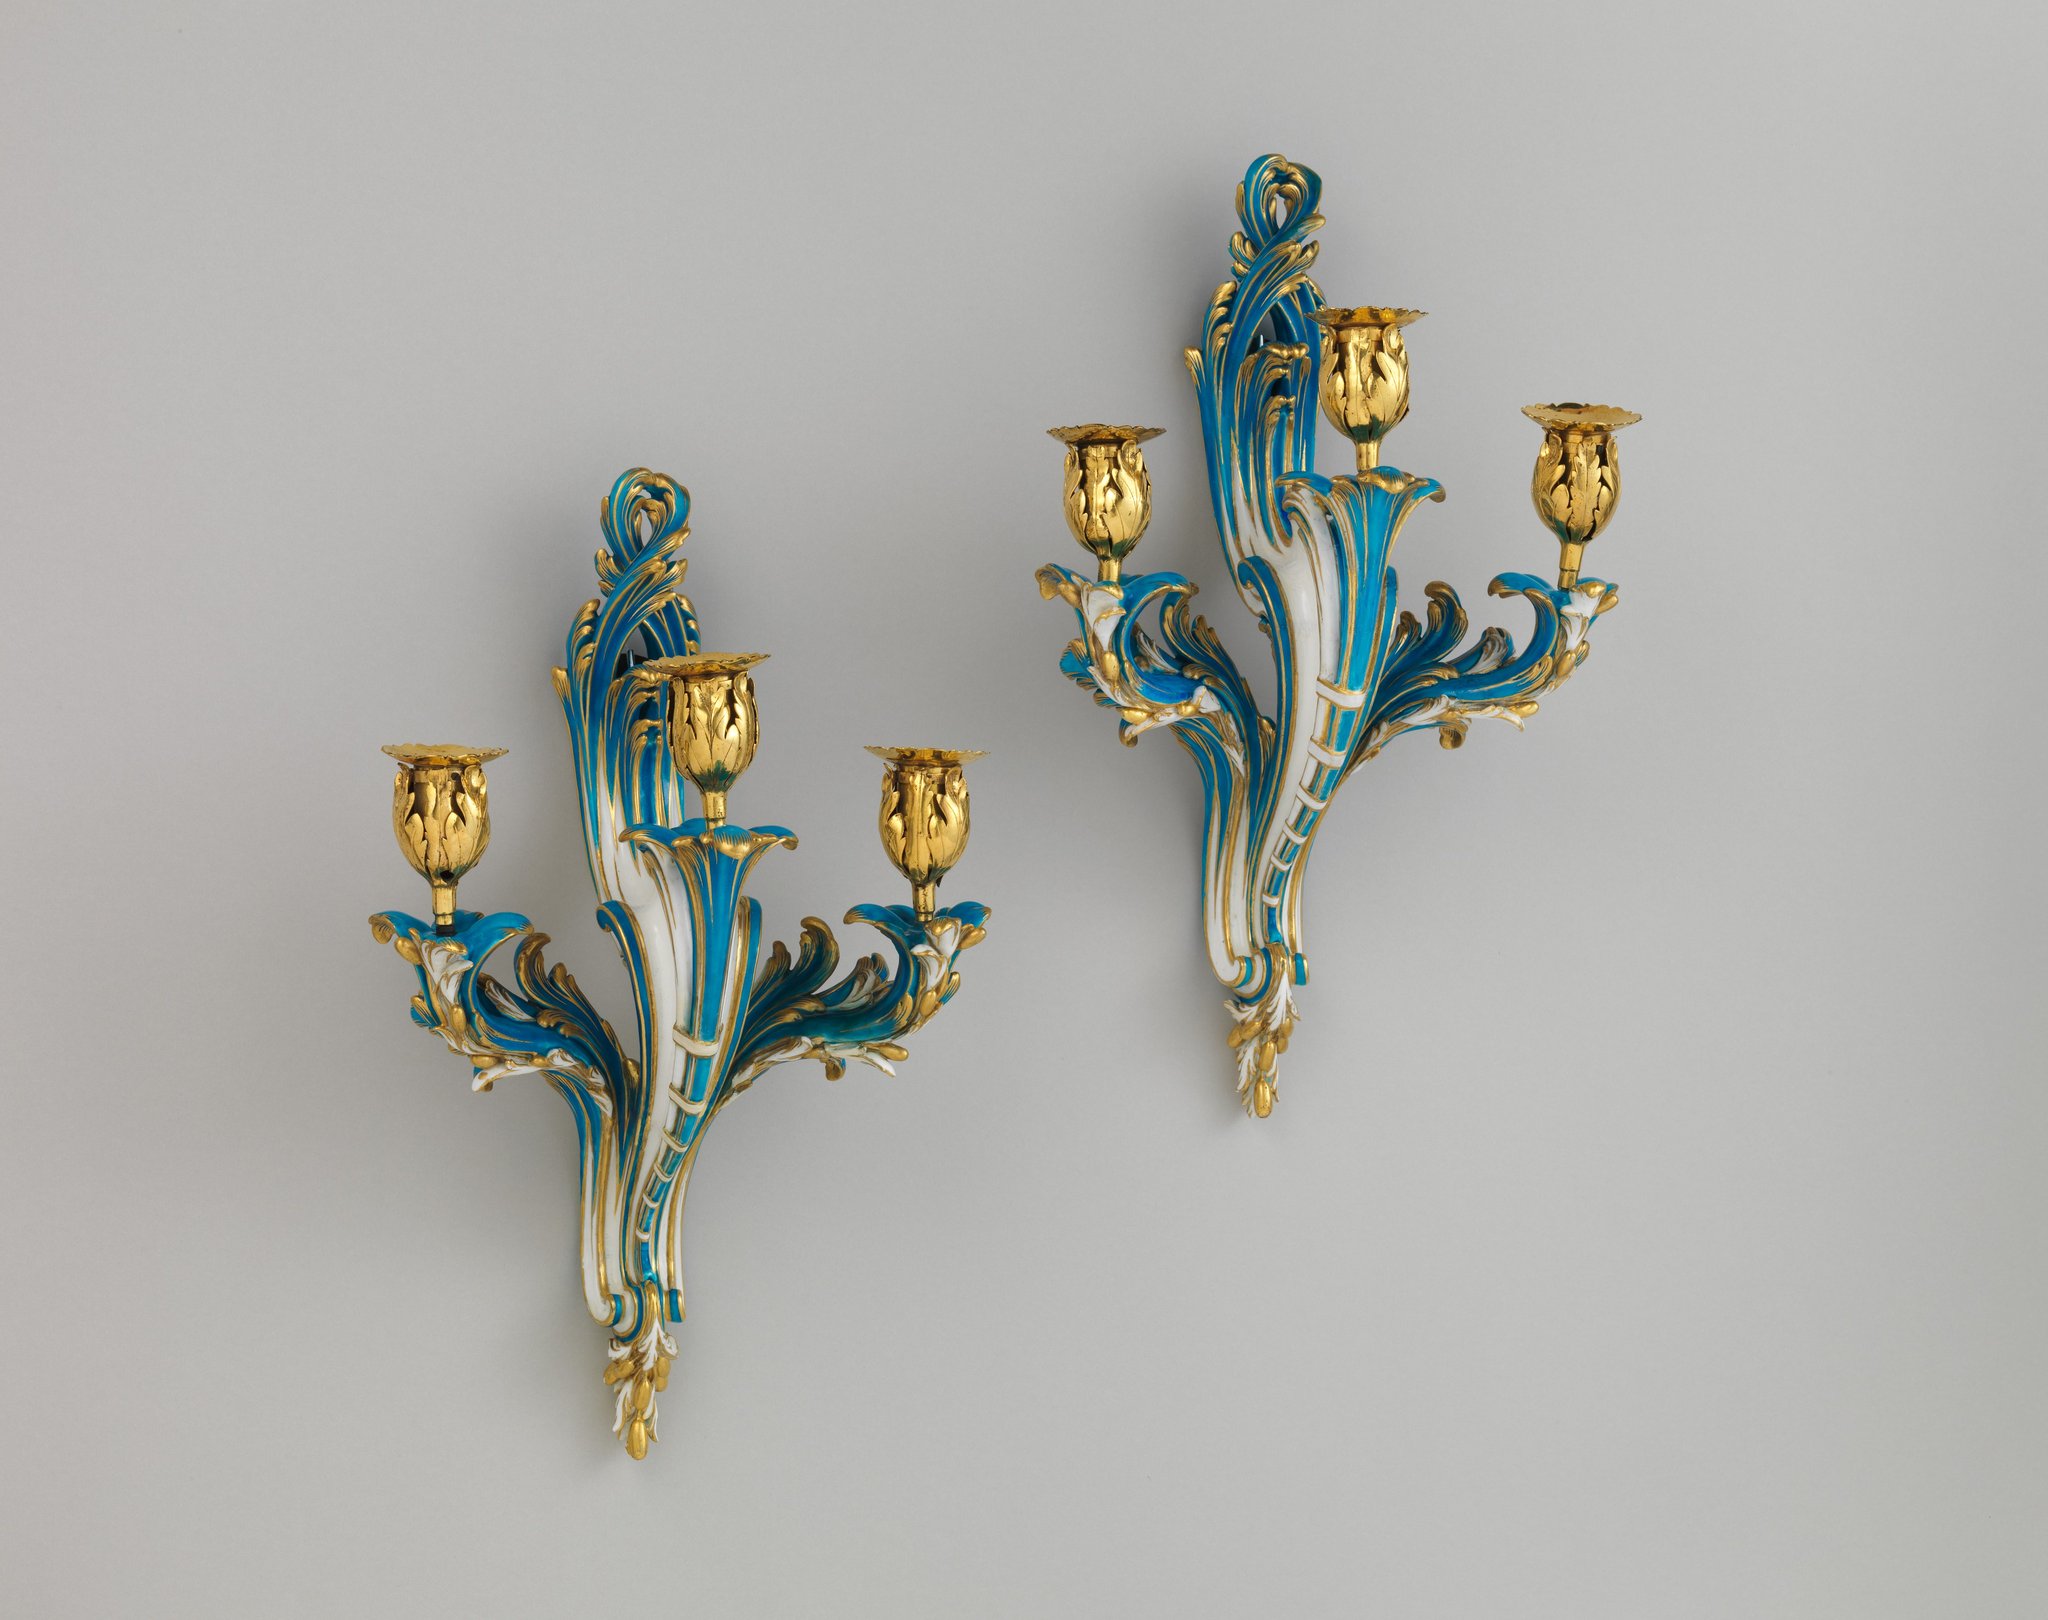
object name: wall light sconce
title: Two wall sconces (Bras de cheminée)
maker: jean-claude duplessis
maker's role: modeler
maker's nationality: french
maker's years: 1695-1774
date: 1761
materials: enamel, gilt bronze, gold, soft paste porcelain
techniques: polychrome